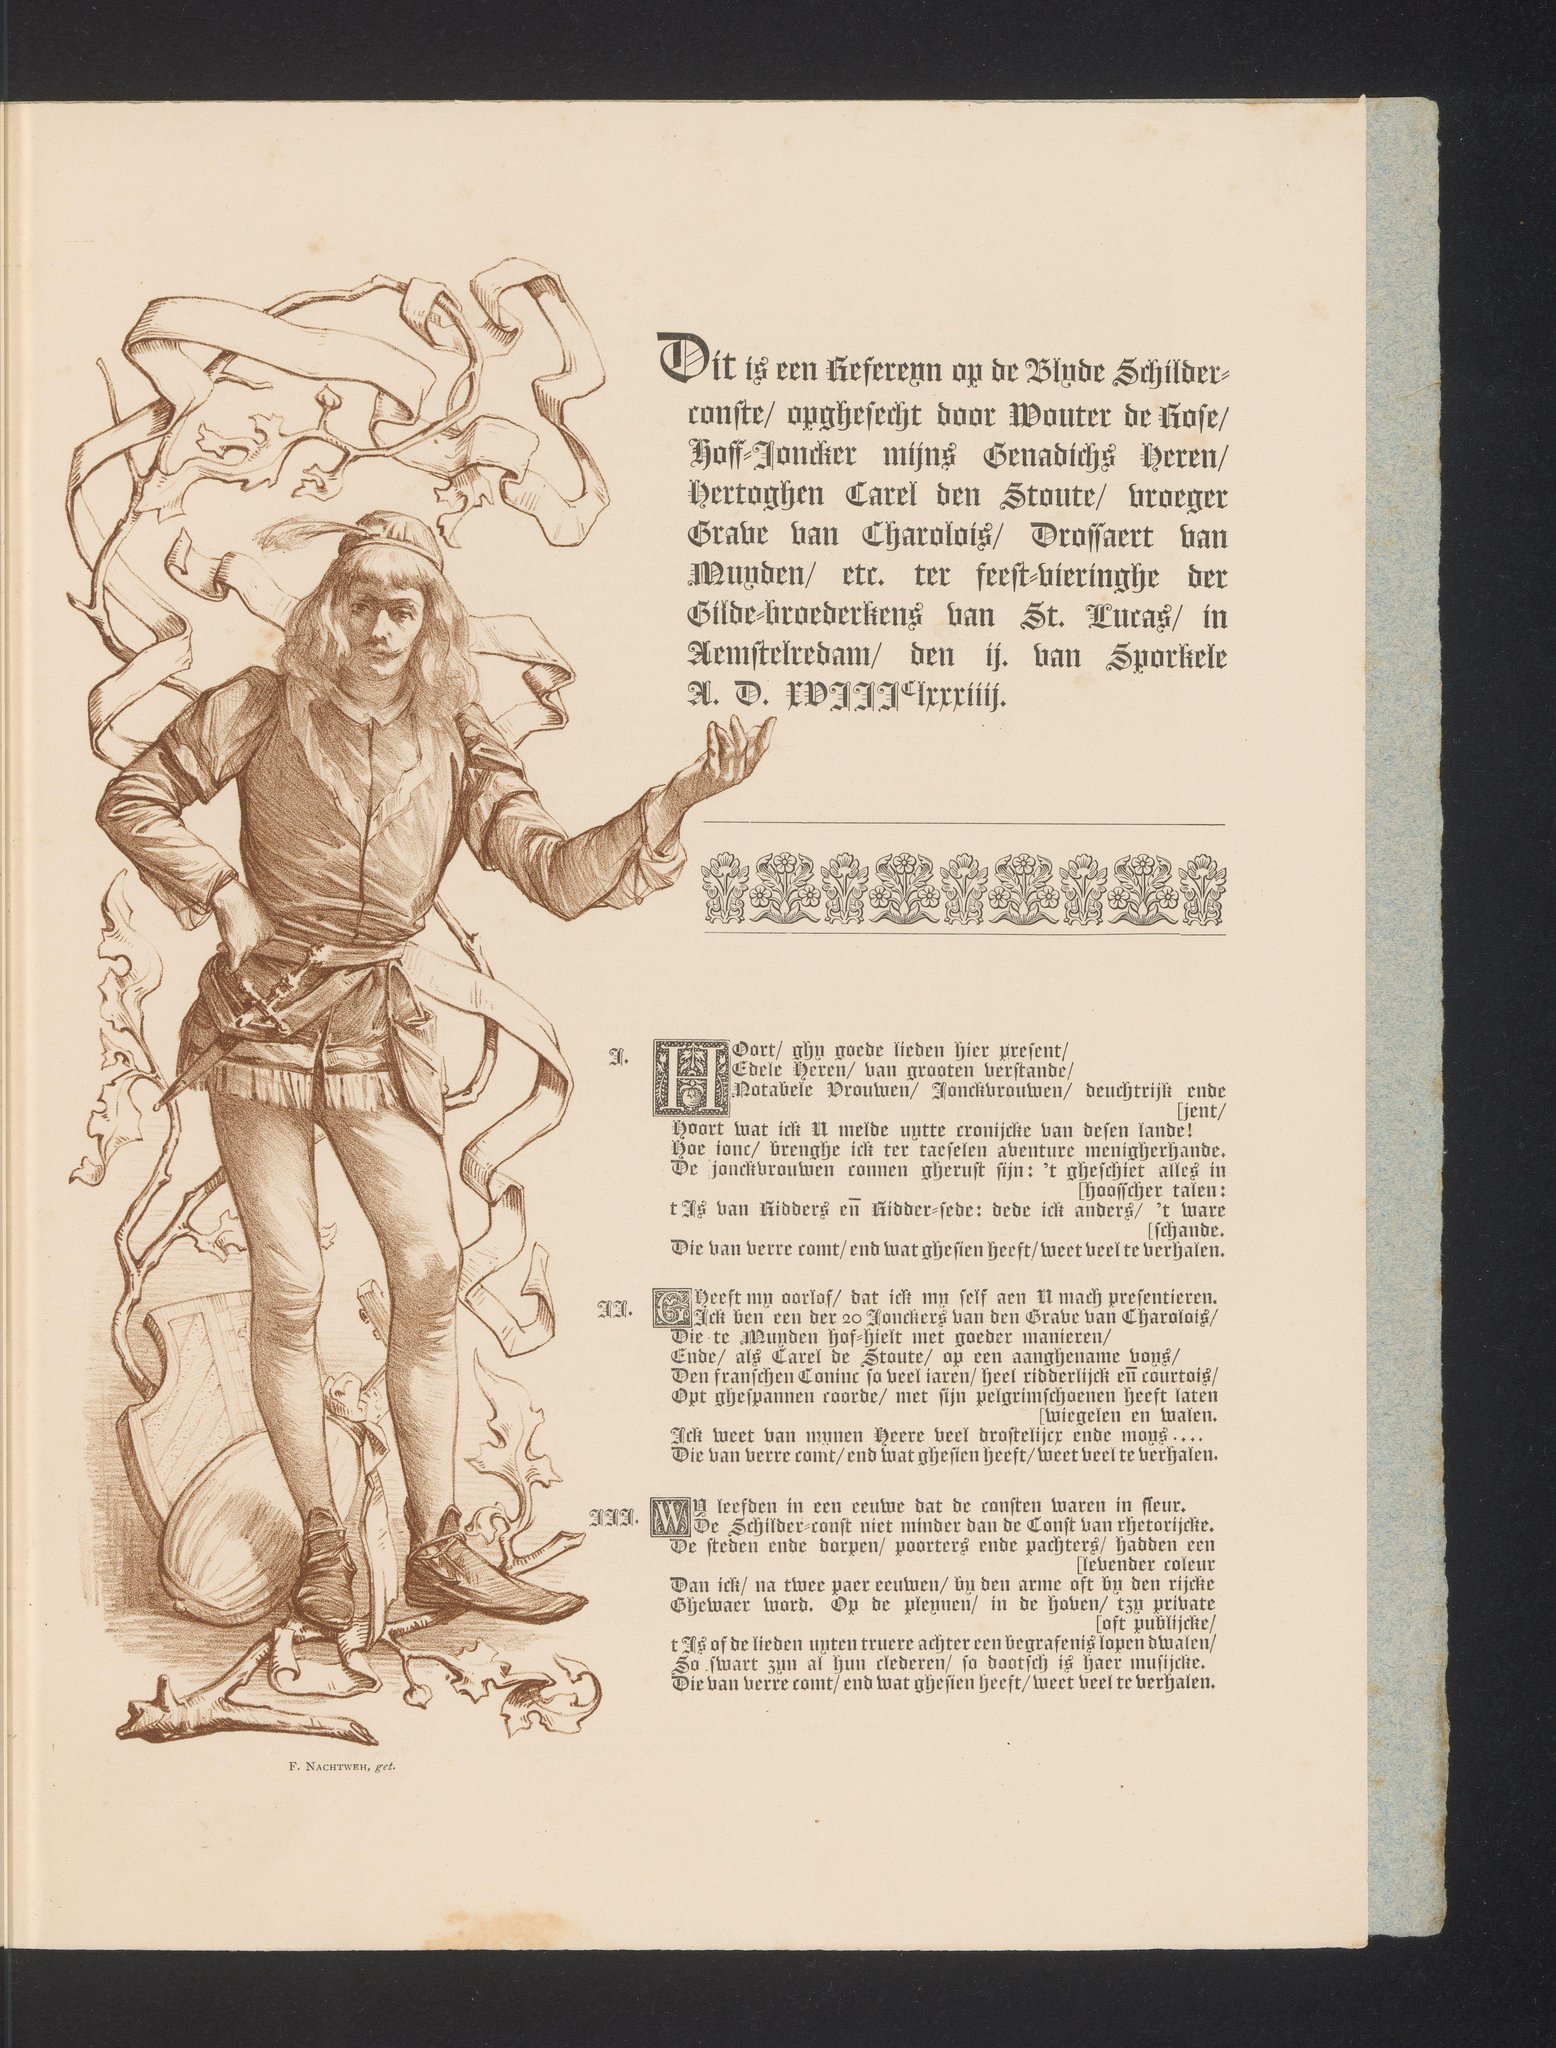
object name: print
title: Middeleeuwse minstreel bij een beschrijving van een de dans 'prince-menuet'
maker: frederik nachtweh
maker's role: print maker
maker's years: 1857-1941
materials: paper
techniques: letterpress printing, lithograph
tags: ball, formal dance, minstrel, 'jongleur' - cc - out of doors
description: Middeleeuwse minstreel is afgebeeld op de tweede pagina van een beschrijving van de dans 'prince-menuet' op een feest in Maison Stroucken in Amsterdam op 2 februari 1884.